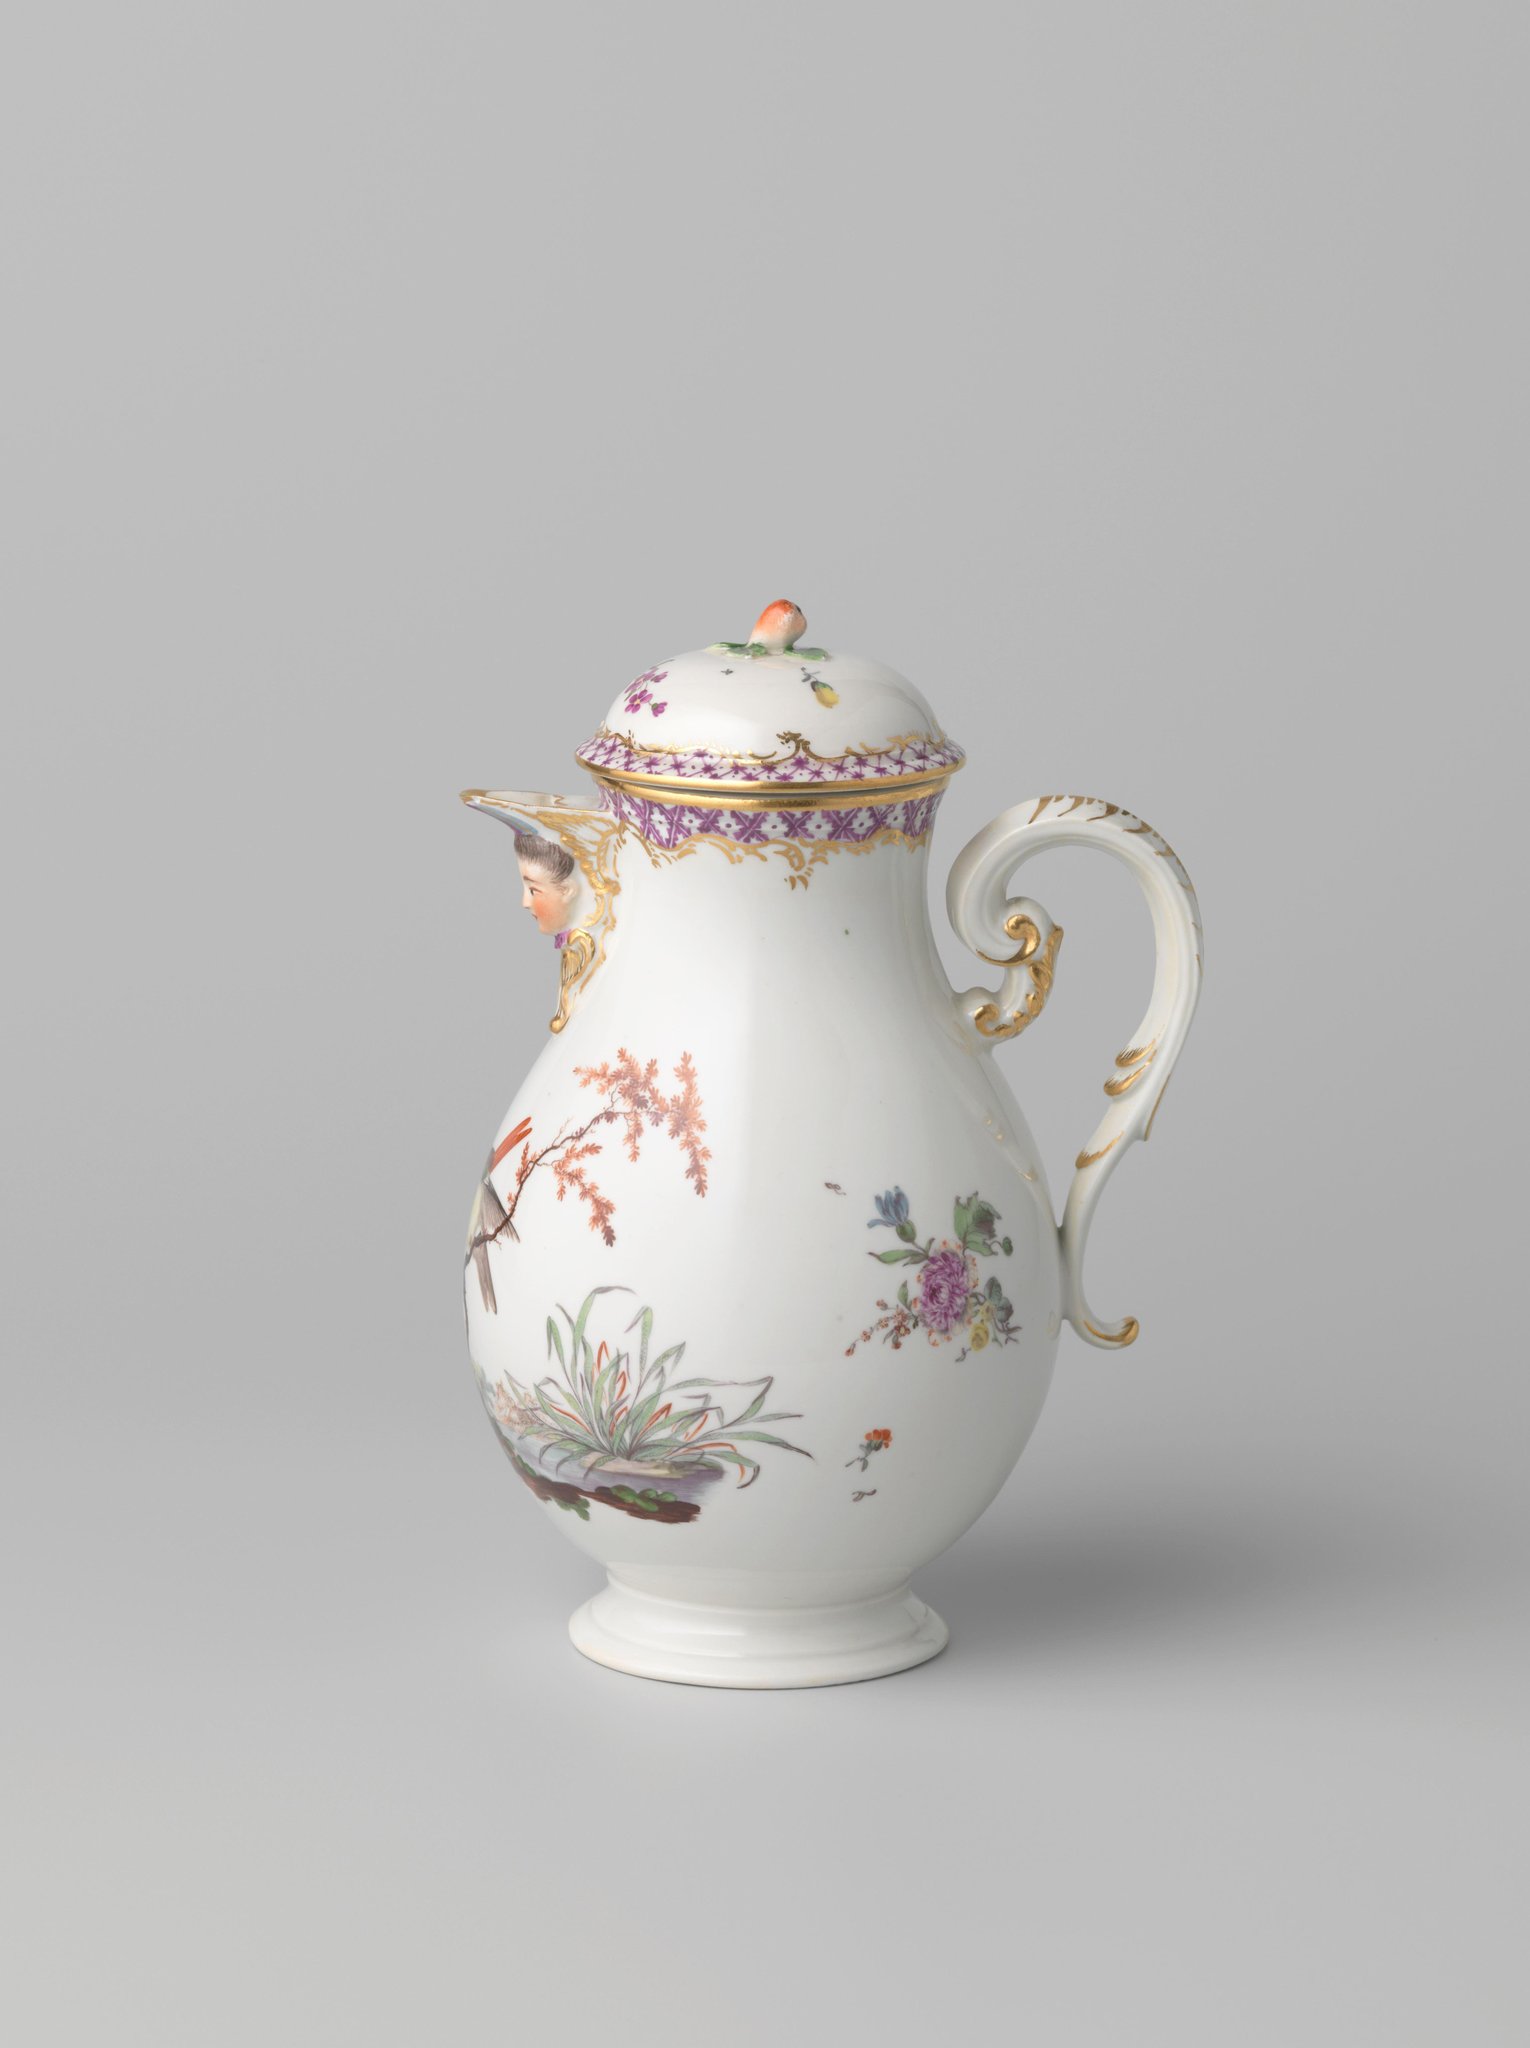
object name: coffee pot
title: Coffeepot with birds in a landscape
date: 1765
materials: glaze, gold, paint, porcelain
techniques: firing, forming, gilding, turning, vitrification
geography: ansbach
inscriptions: mark: ‘A/ I/ 4’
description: Koffiekan van porselein op spreidende voet met een peervormig lichaam, driehoekige tuit vanuit de nek en een gekruld oor in de vorm van een bladrank. Beschilderd op het glazuur in emailkleuren en goud. Op de buik drie vogels in een landschap, waarbij twee op een tak zitten en één op de grond. Aan weerszijden hiervan een boeket en strooibloemen. Op de rand een band met servetwerk, waaronder gouden ranken. De tuit is gemodelleerd in een engelenkop met vleugels. Het gekrulde oor is aangezet met goud en eindigd in een palmet. De deksel met strooibloemen heeft dezelfde band met servetwerk; dekselknop in de vorm van een fruittak (peer). Gemerkt op de onderzijde met de A, I en 4.